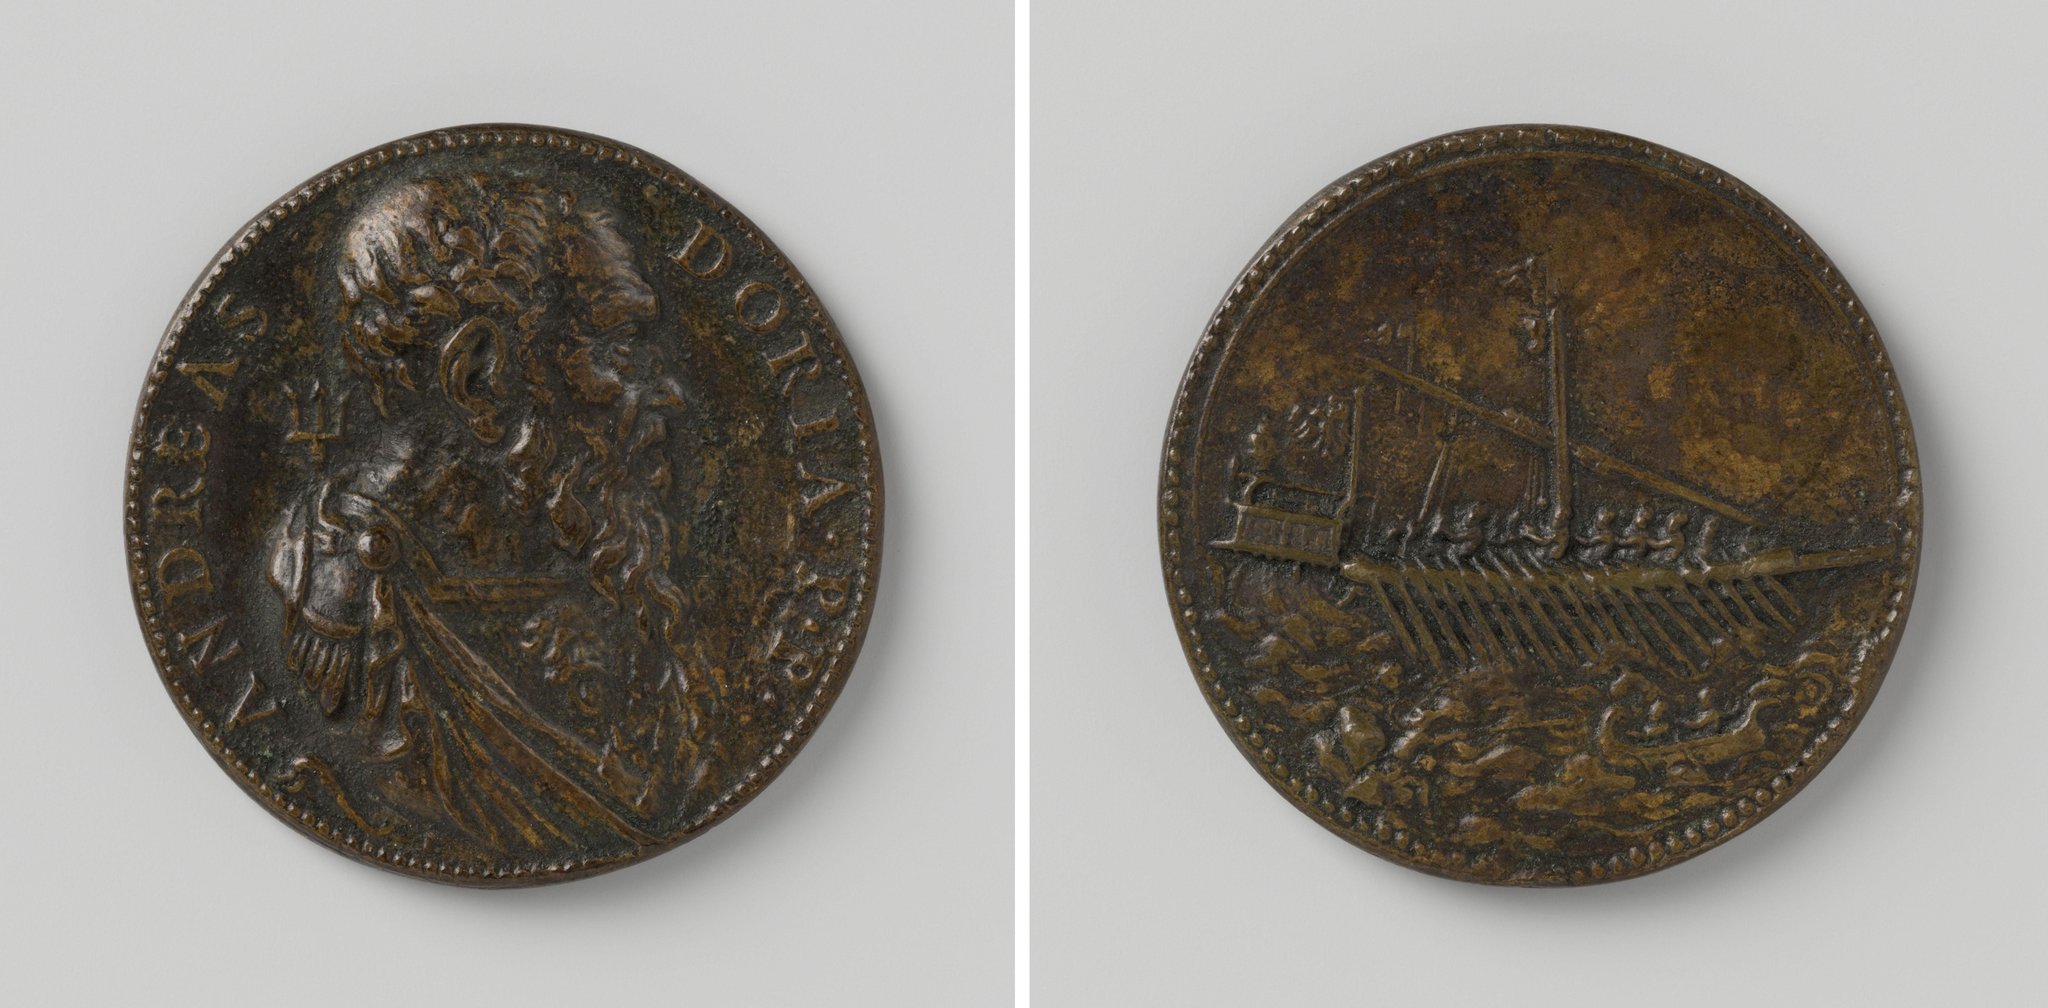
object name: history medal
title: Admiraal Andrea Doria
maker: leone leoni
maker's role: draughtsman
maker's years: 1509-1590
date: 1537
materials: bronze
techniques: casting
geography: italy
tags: draughtsman, leone leoni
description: Bronzen penning. Voorzijde: borststuk man met achter zich drietand binnen omschrift. Keerzijde: galei, op voorgrond nadert bootje met twee mannen [zinspeling op bevrijding van Leonidoor Doria]